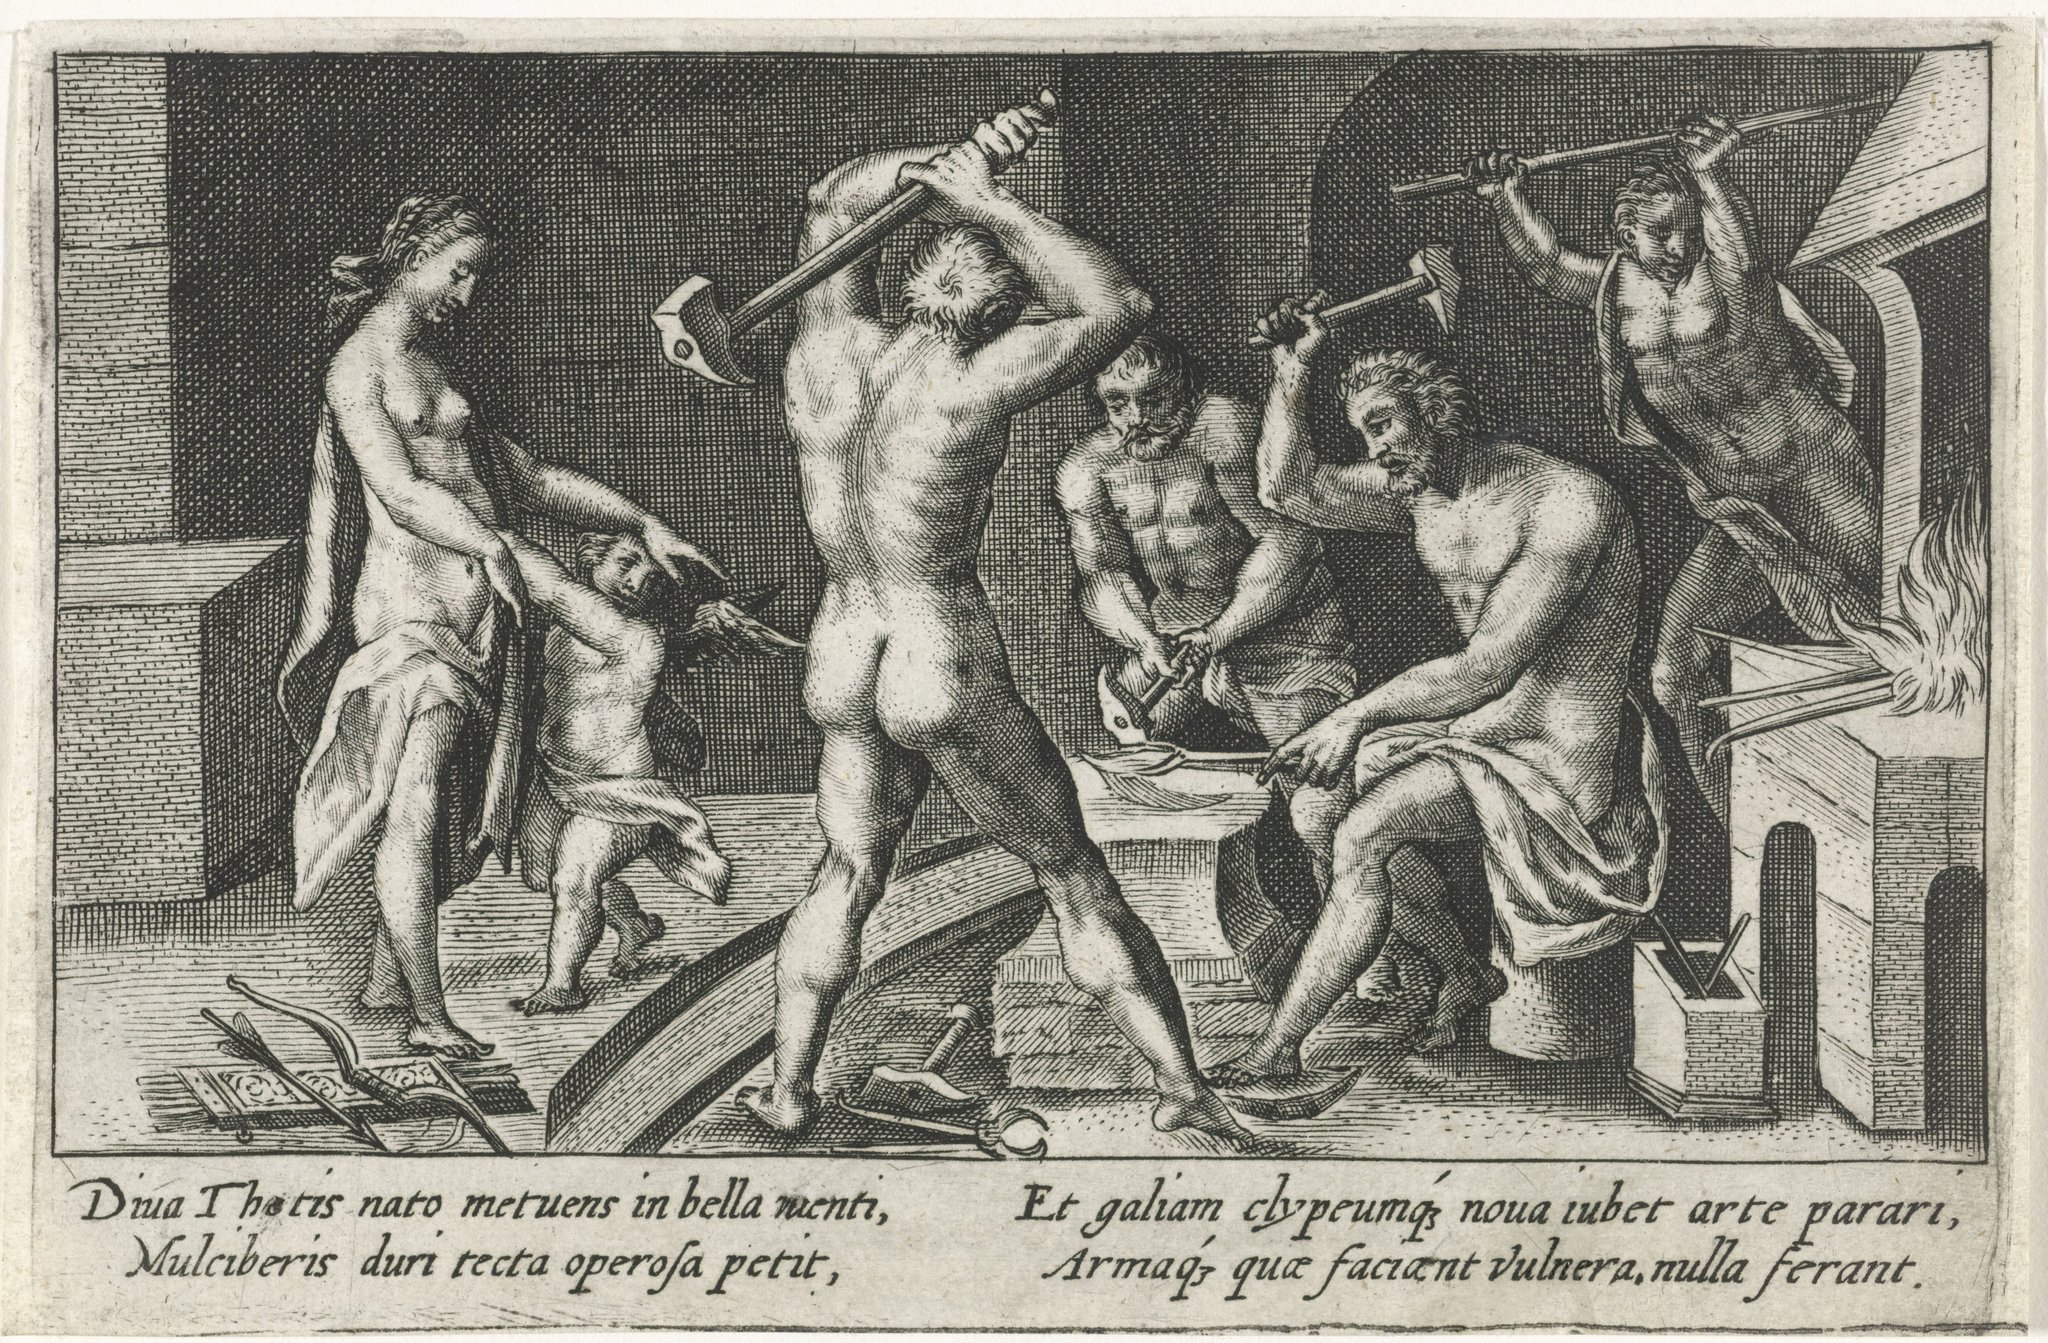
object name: print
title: Venus in de smidse van Vulcanus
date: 1602-1607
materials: paper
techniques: engraving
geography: cologne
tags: venus asks vulcan to forge aeneas' armour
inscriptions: collector's mark: Lugt 2228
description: Venus vraagt Vulcanus een wapenrusting te vervaardigen voor haar zoon Aeneas, voor als hij ten strijde trekt in Latium. In de marge een vierregelig onderschrift, in twee kolommen, in het Latijn.